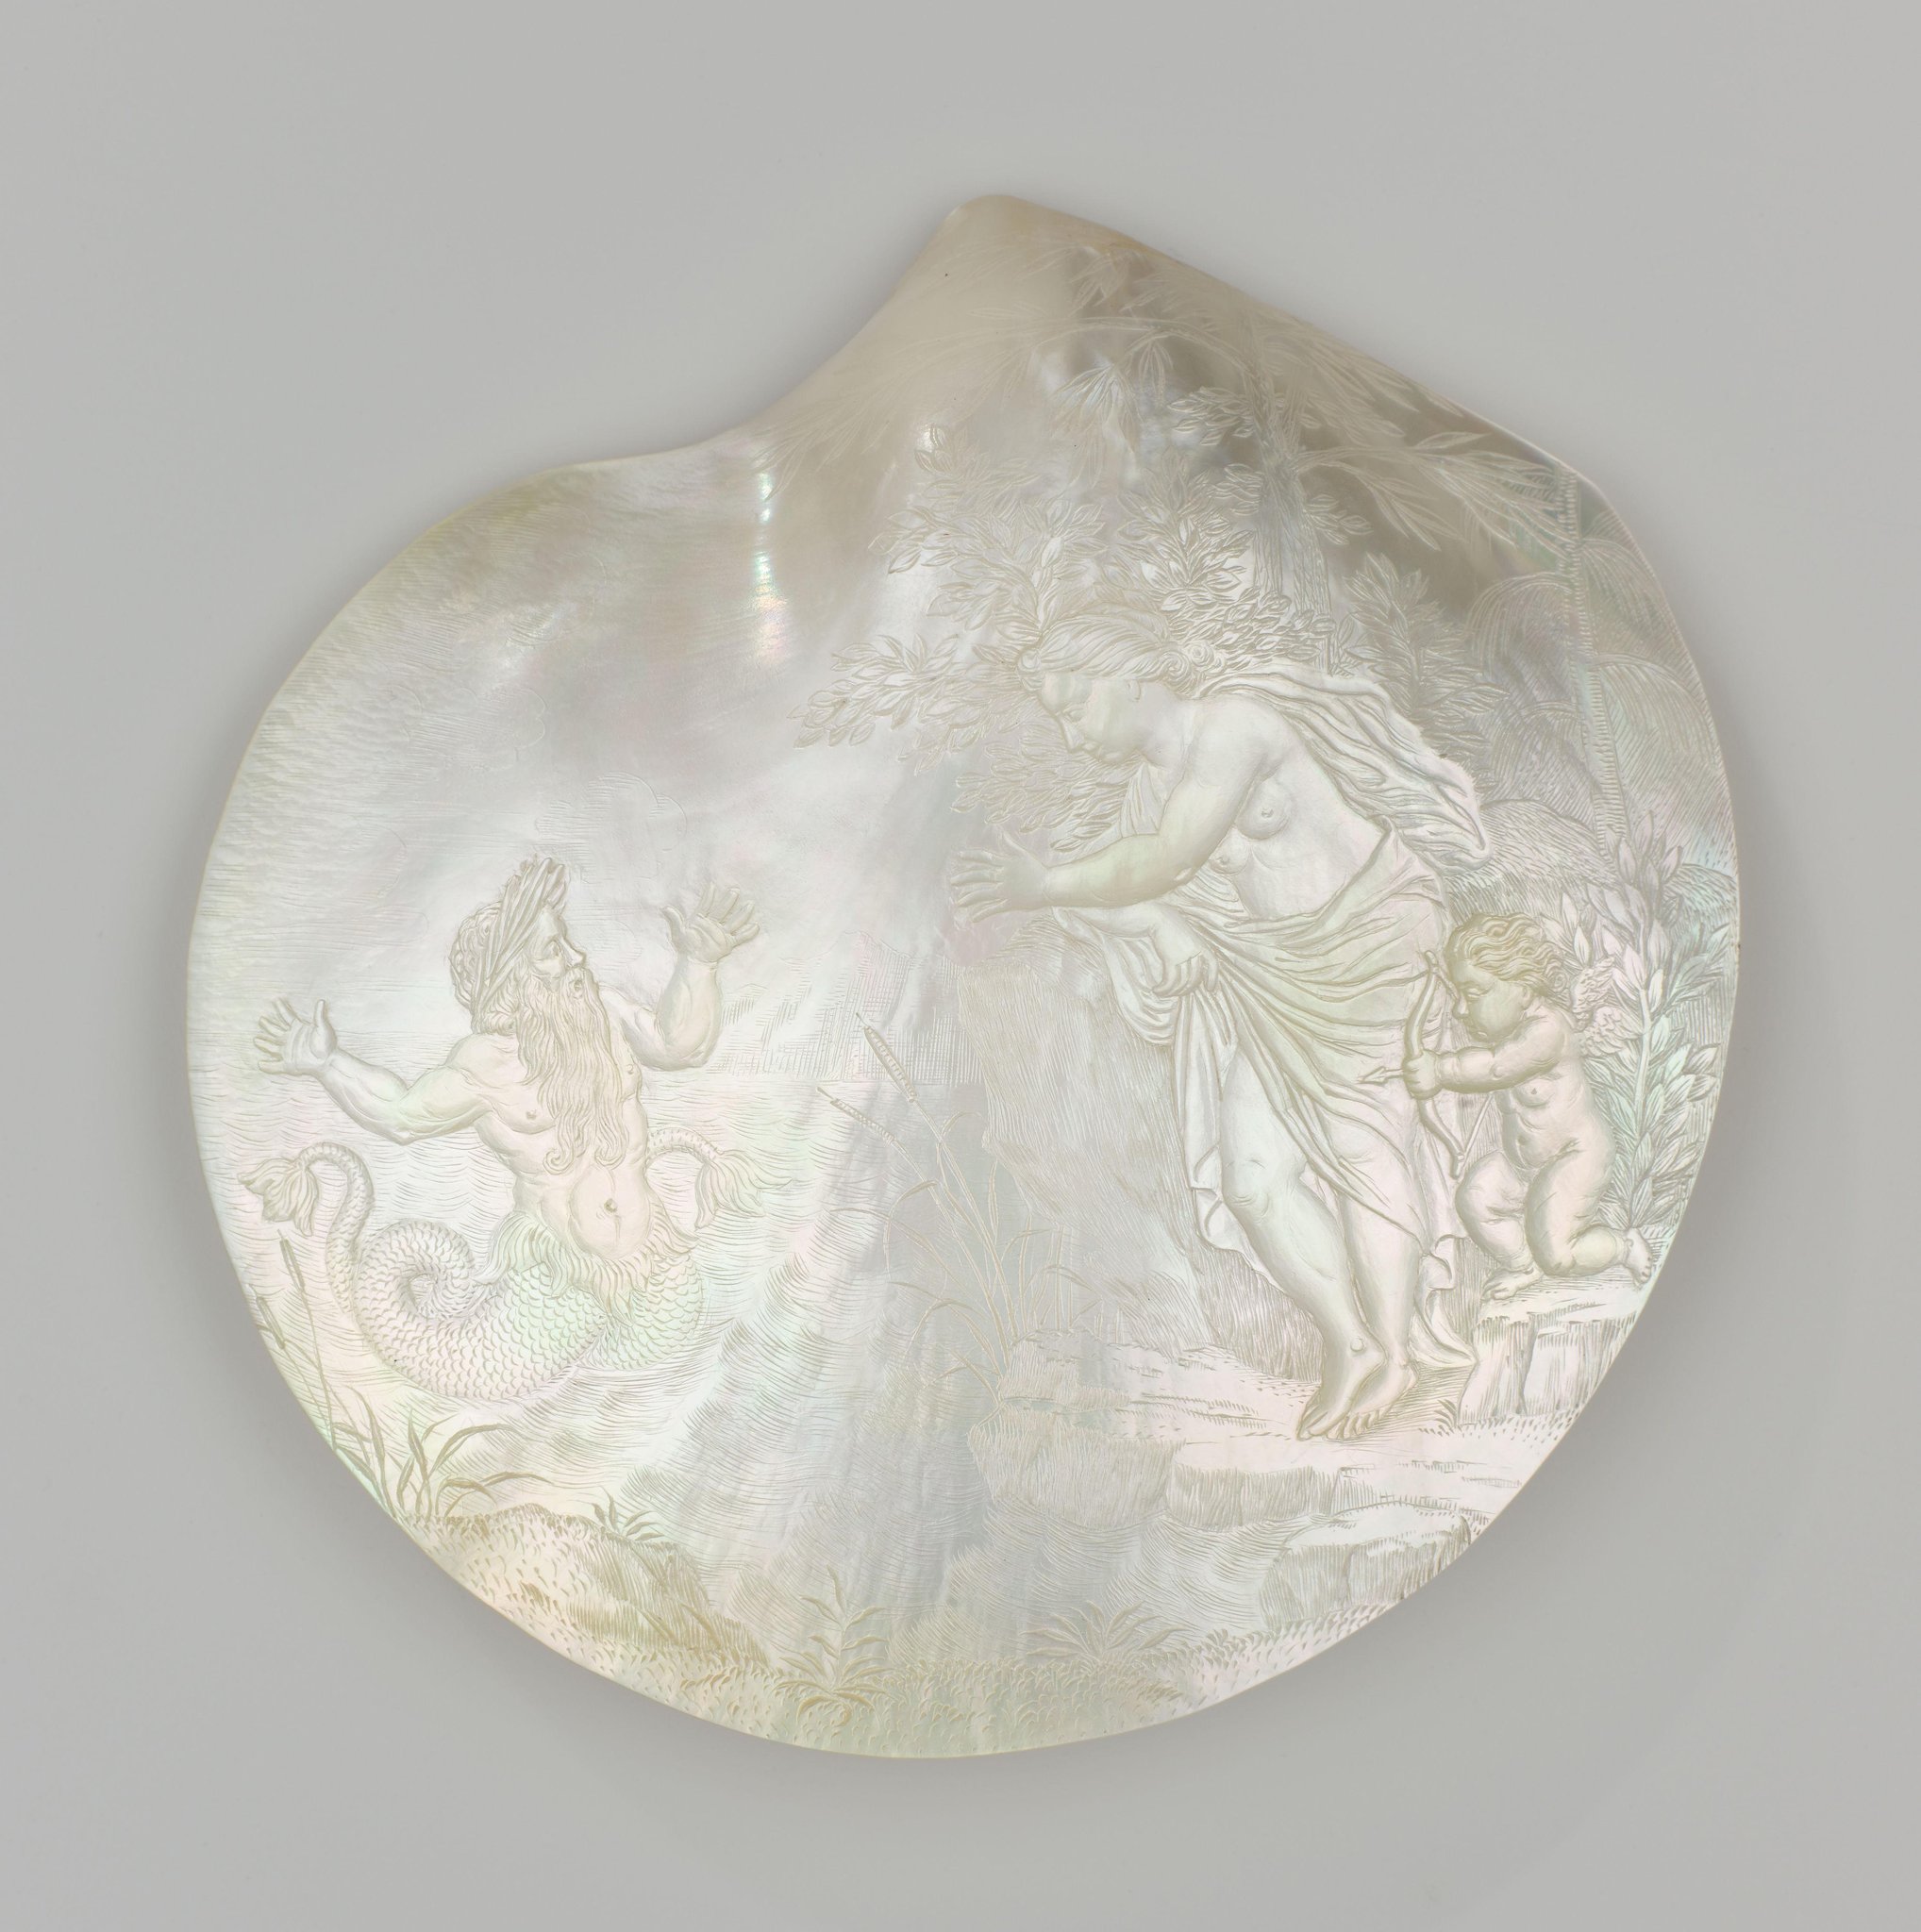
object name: sculpture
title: Two carved shells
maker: cornelis bellekin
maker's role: jeweler, painter, print maker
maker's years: 1625-1711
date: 1670-1700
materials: mother of pearl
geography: amsterdam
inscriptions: inscription, on the reverse, incised: ‘Glaucus Scylla’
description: Bellekin transformed nature into art, producing objects perfectly in keeping with the 17th-century concept of a collection of rarities. VOC ships brought back oyster shells from the Indian Ocean, which Bellekin carved with scenes from Greek mythology in low relief: Perseus on his winged horse rescuing Andromeda, and the nymph Scylla reaching out to the sea god Glaucus.